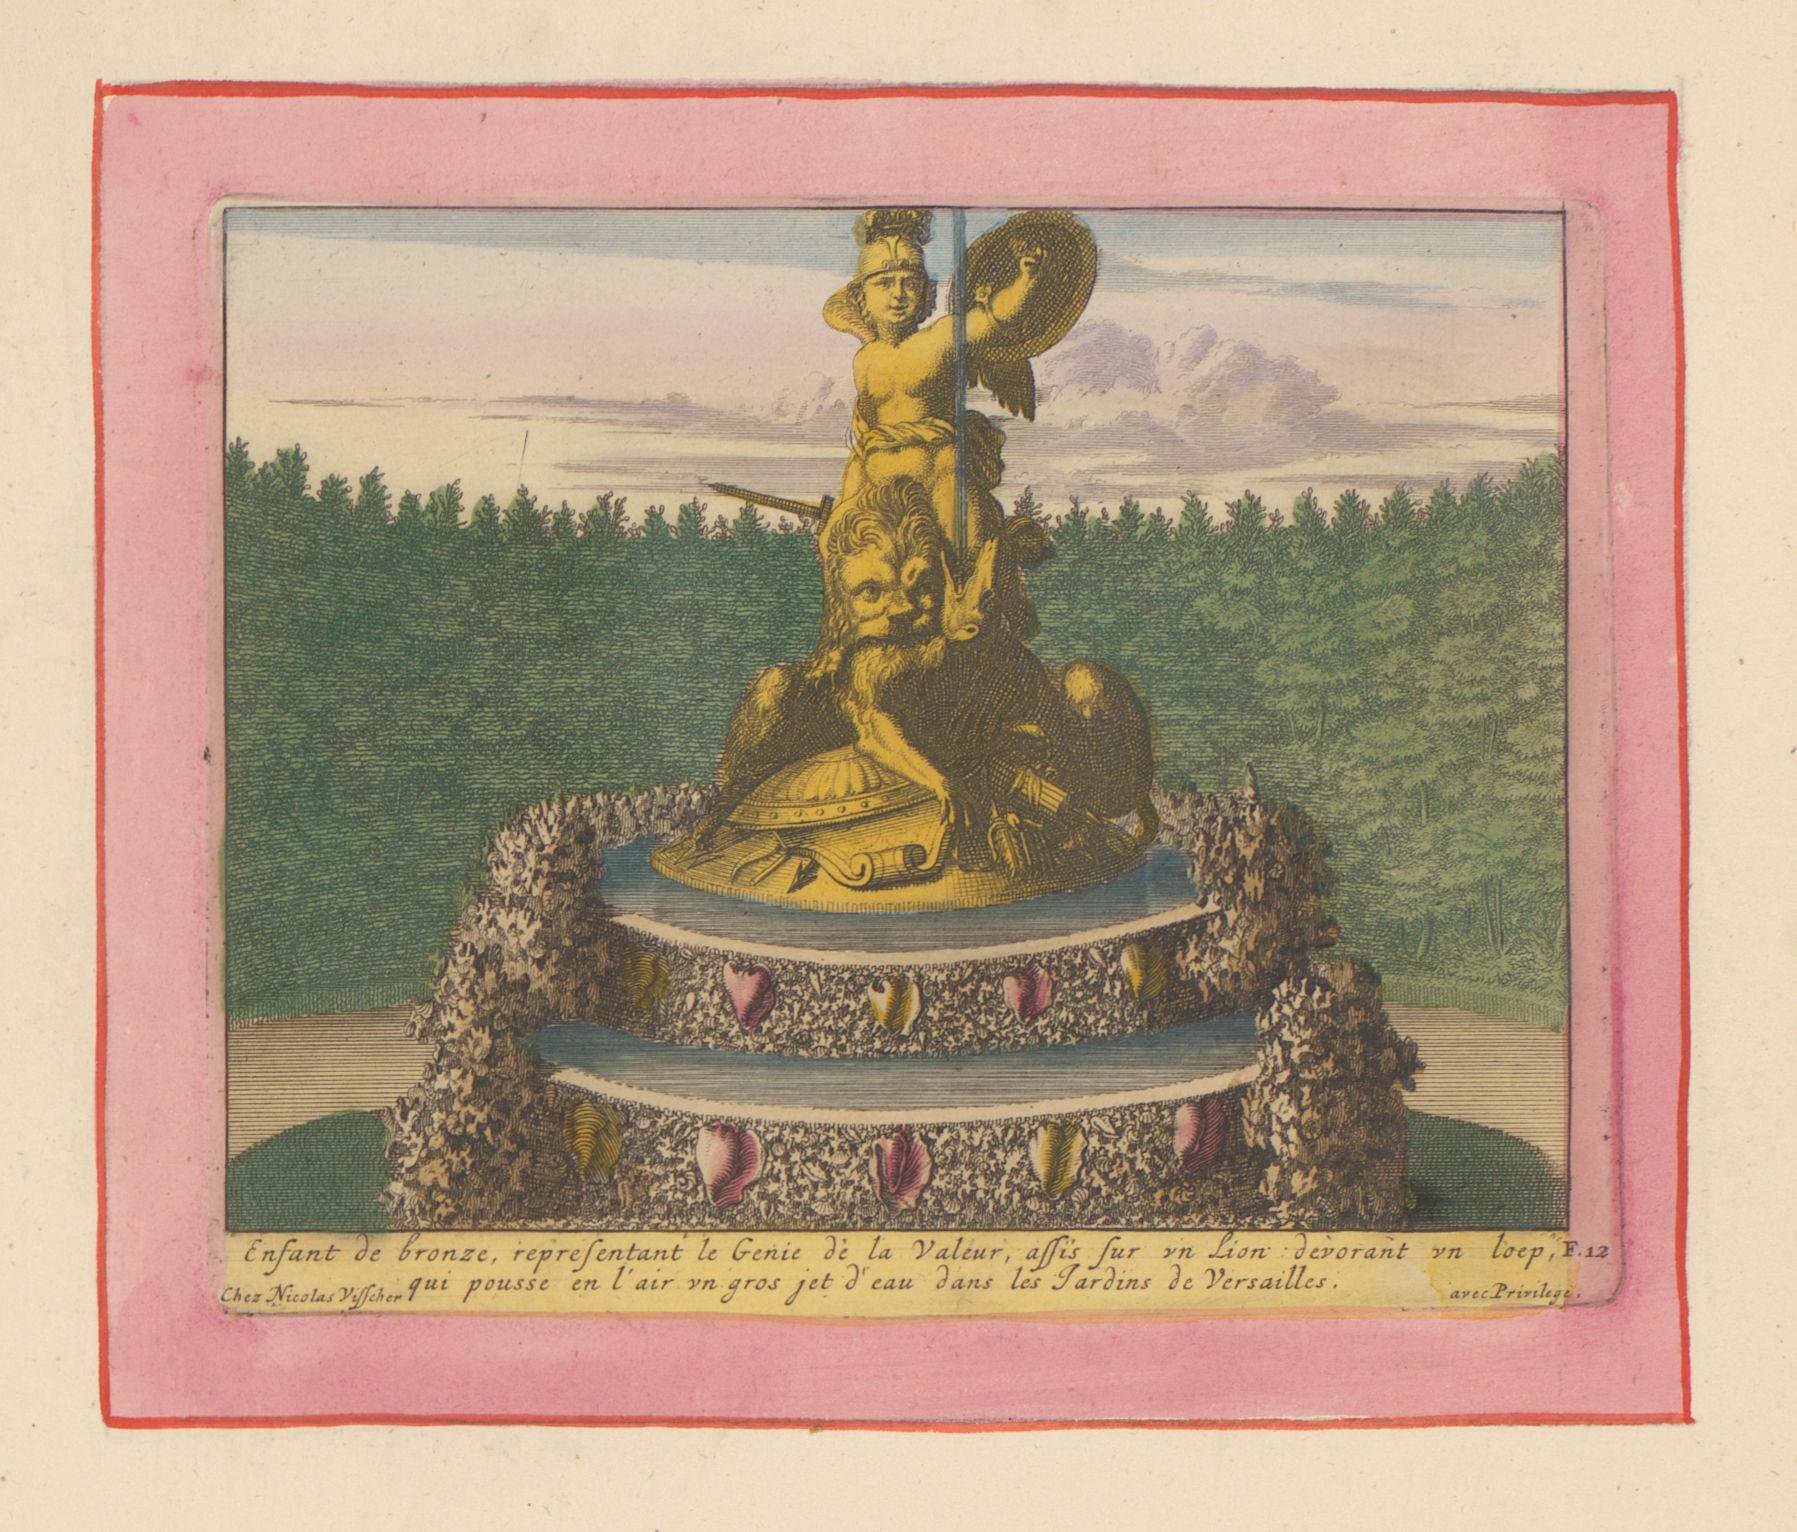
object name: album leaf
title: Veues de Versailles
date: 1686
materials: paper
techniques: etching, hand coloring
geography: amsterdam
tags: garden fountain, statues, sculptures in garden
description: Fontein met een gehelmde putto met schild en zwaard gezeten op een leeuw in de tuinen van Versailles. De leeuw verscheurt een wolf. Rechtsonder het serienummer: F12. Prent maakt deel uit van een album.